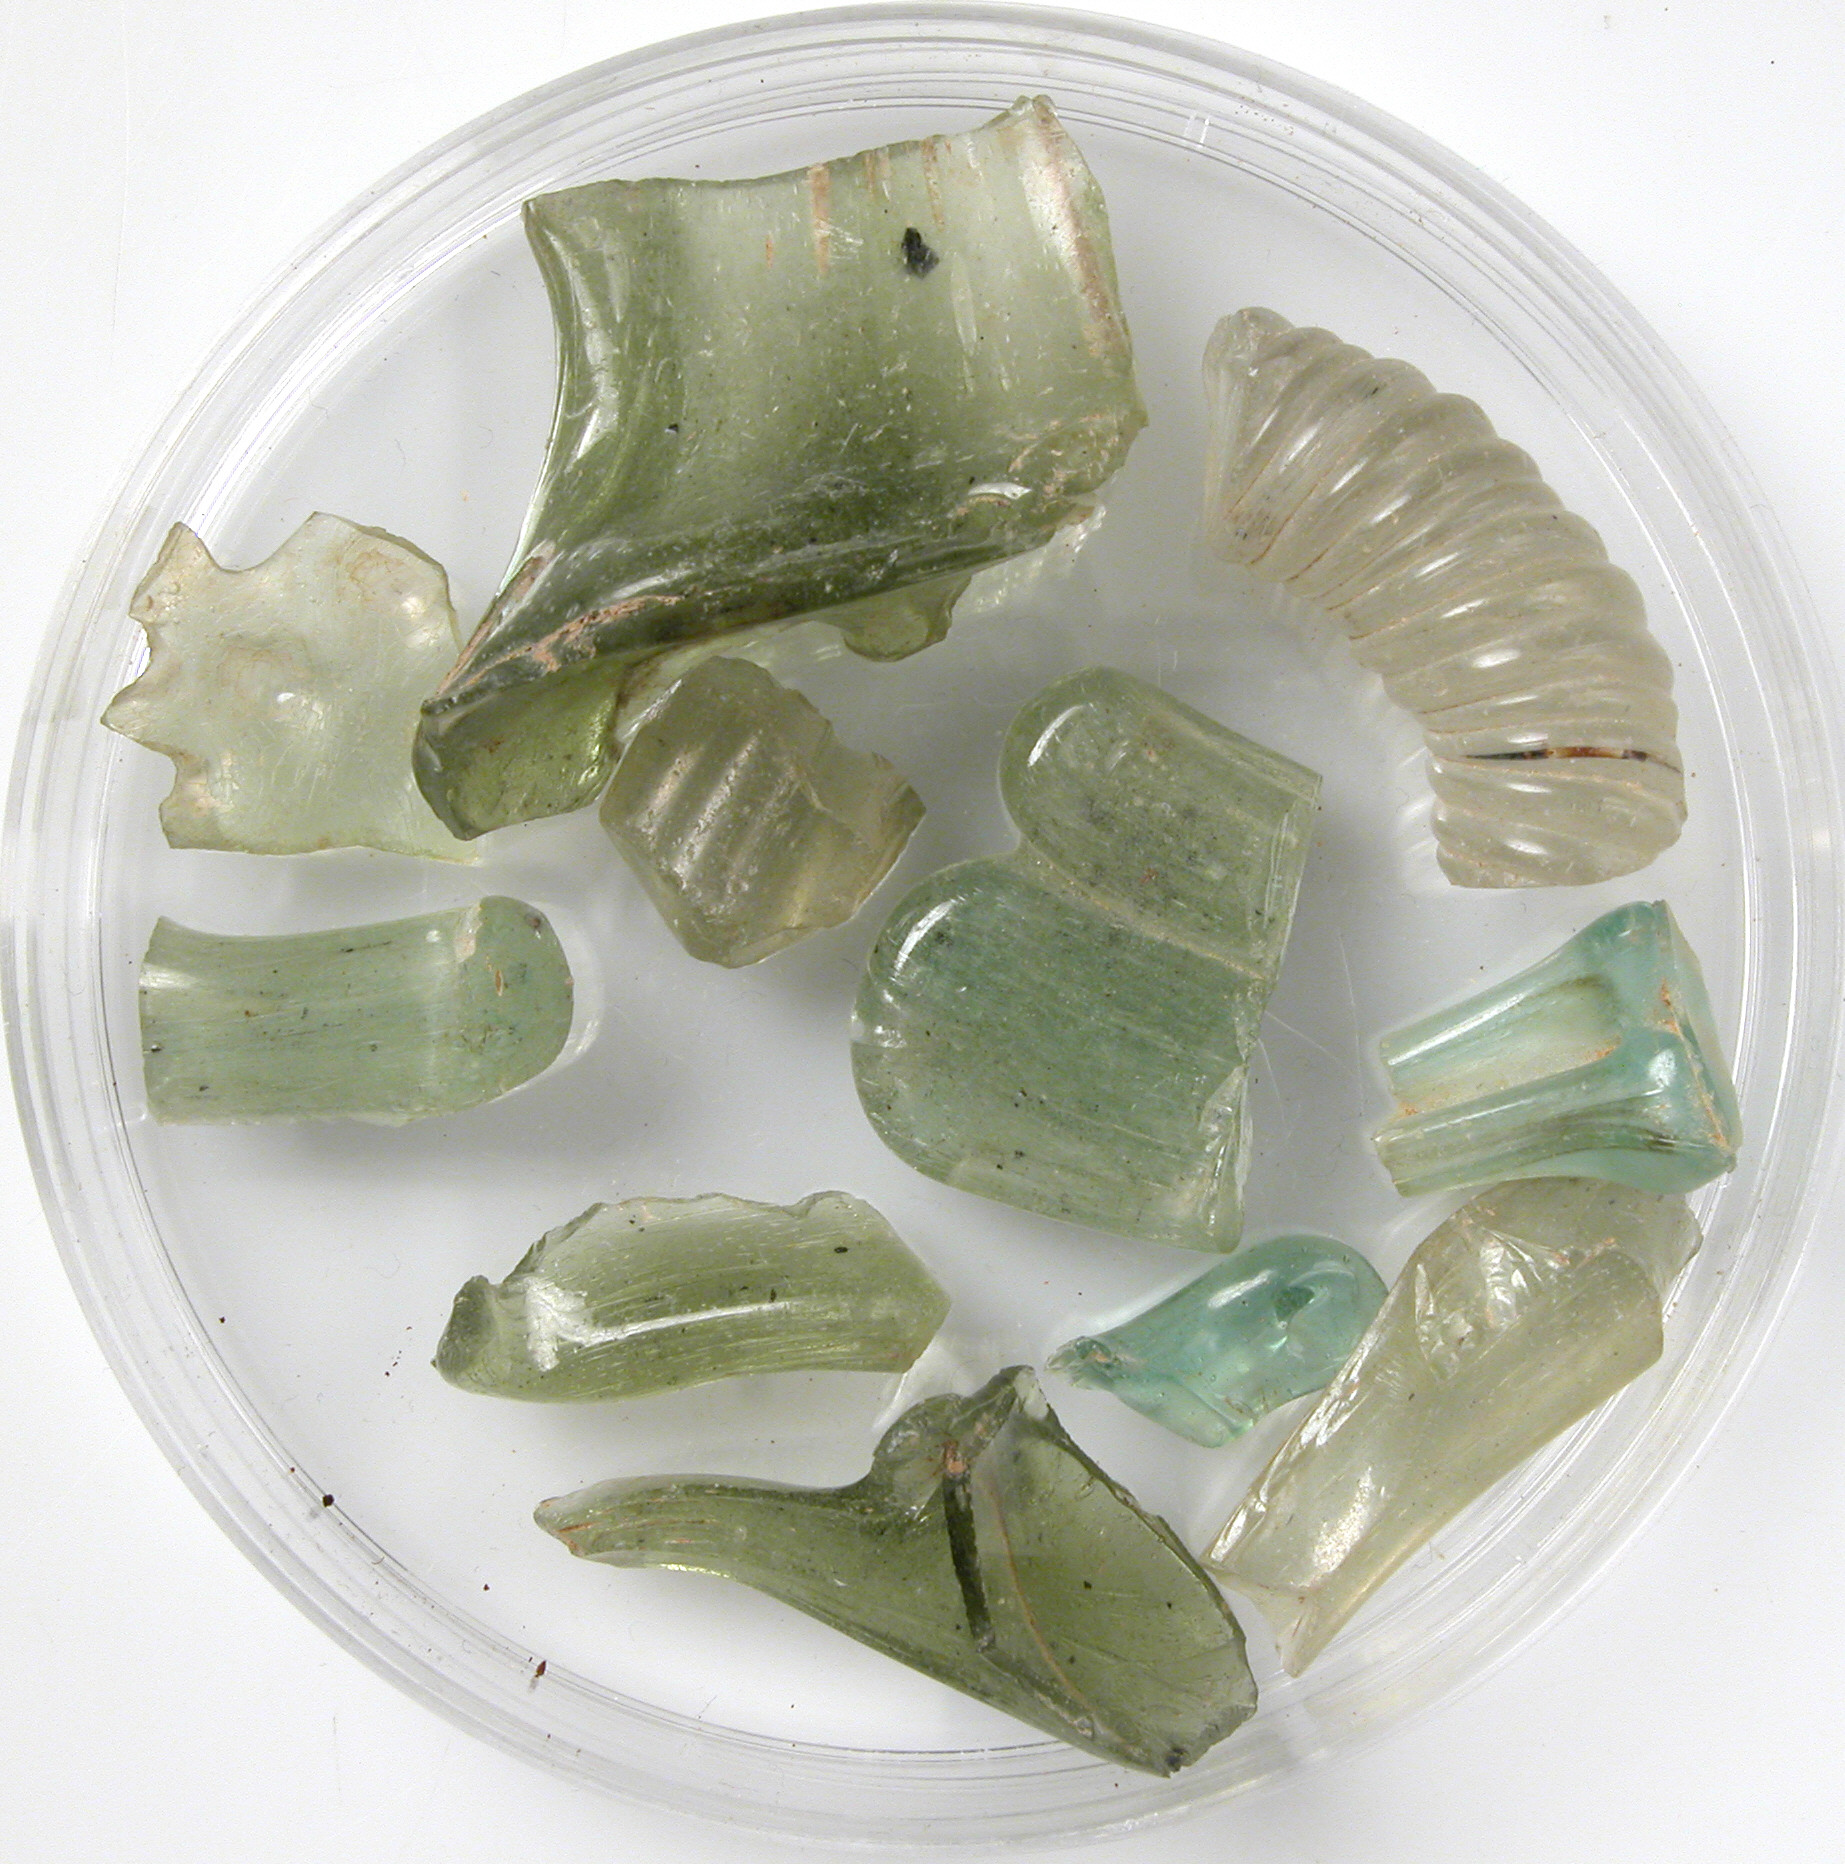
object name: fragment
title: Glass Fragments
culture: coptic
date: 301-700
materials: glass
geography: egypt